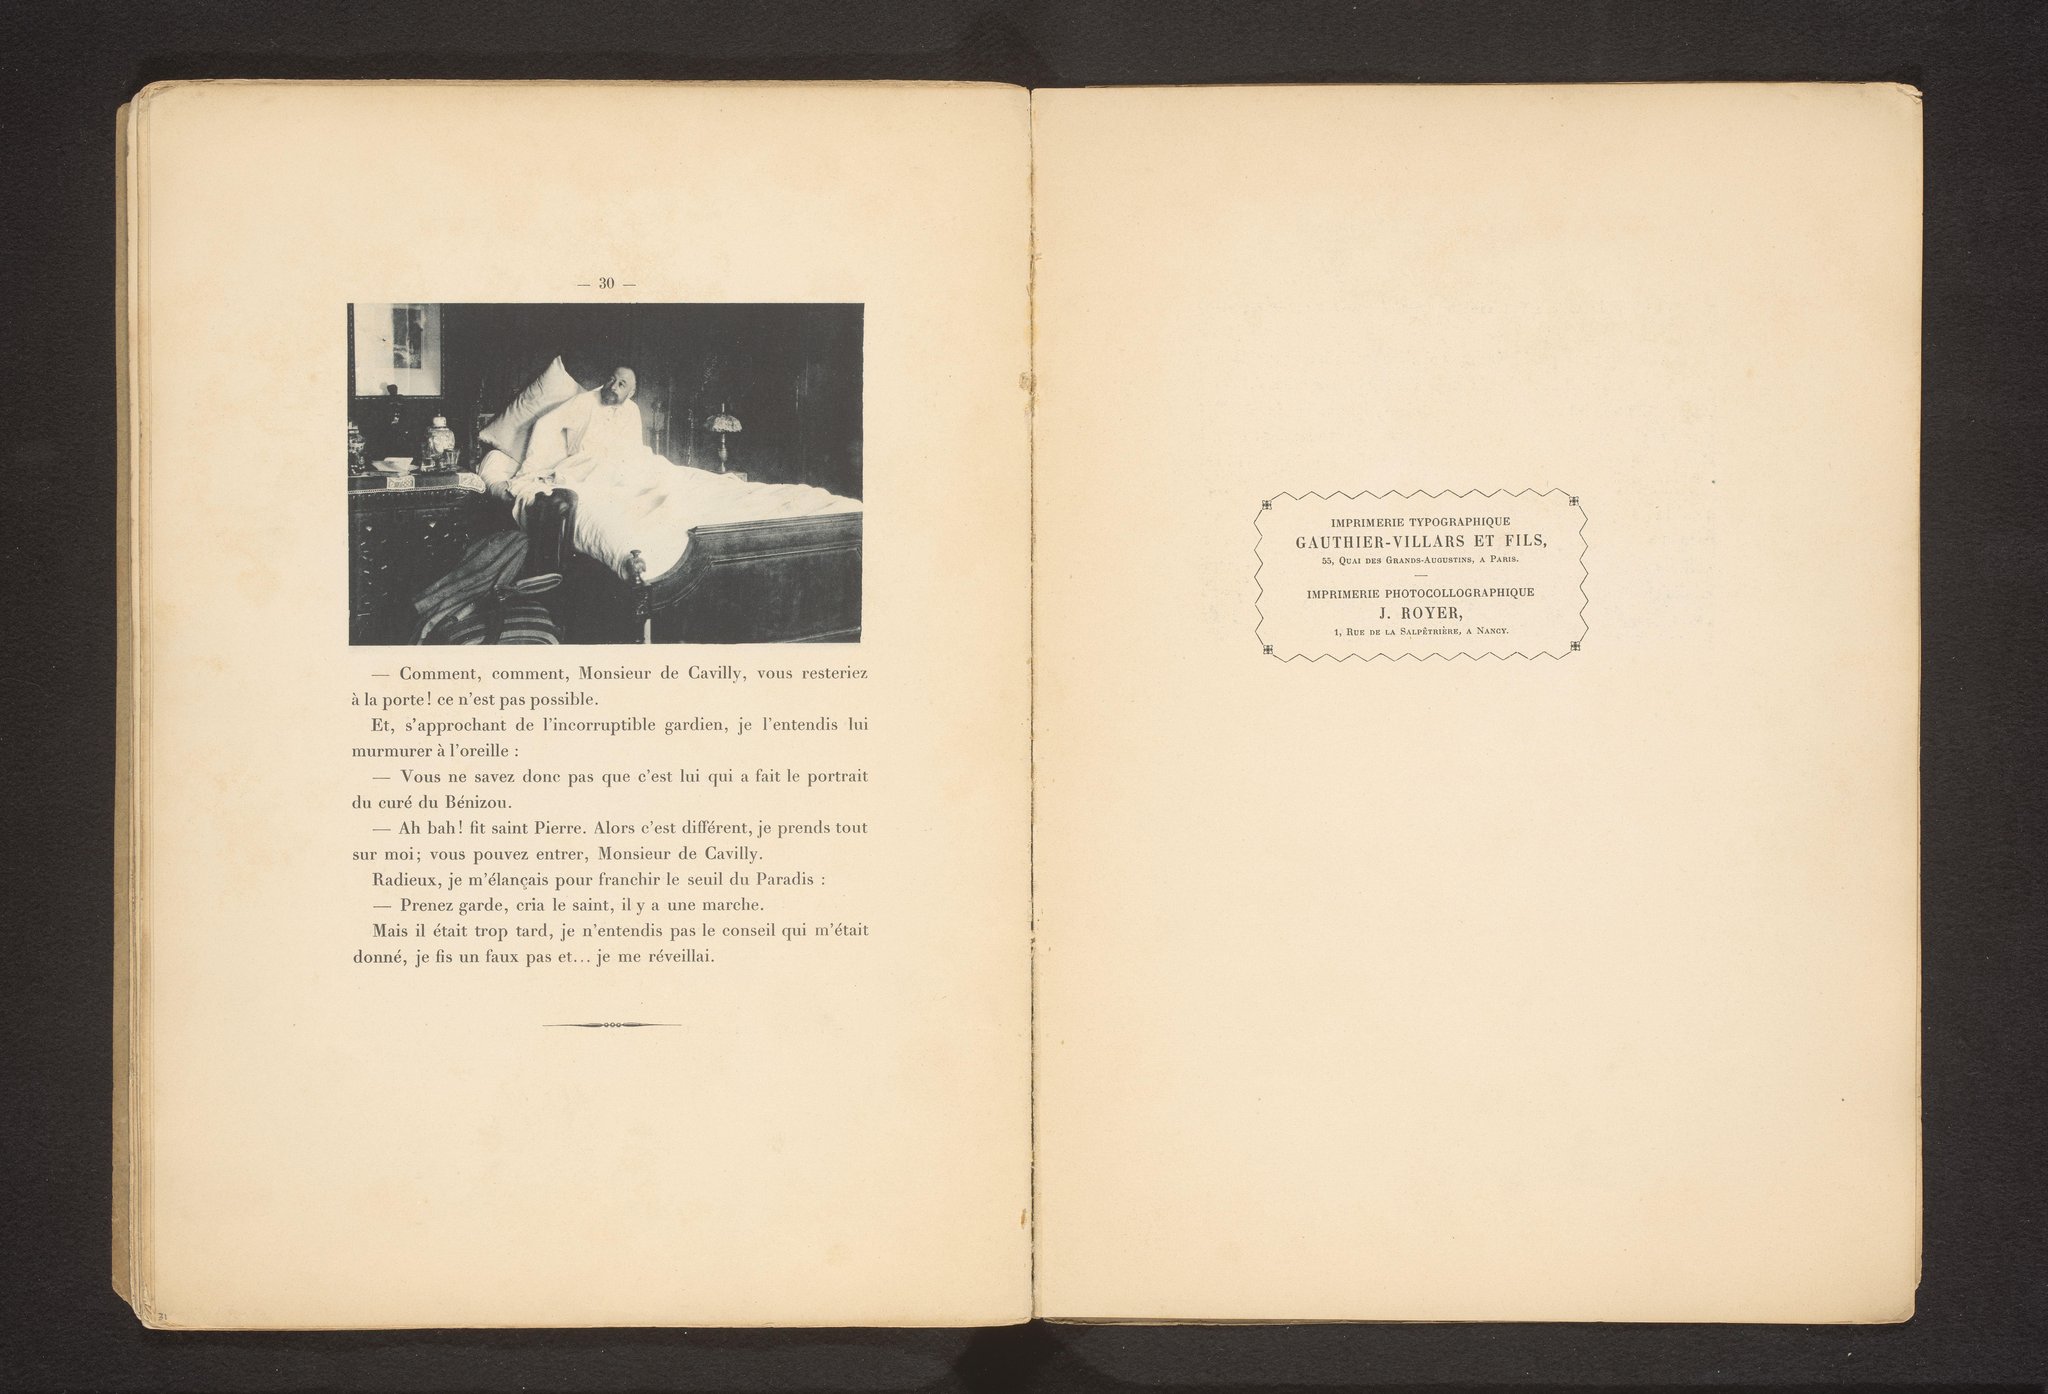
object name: page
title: Man zittend in bed, vermoedelijk Georges de Cavilly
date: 1885-1895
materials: paper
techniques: photograph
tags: georges de cavilly, adult man, bed